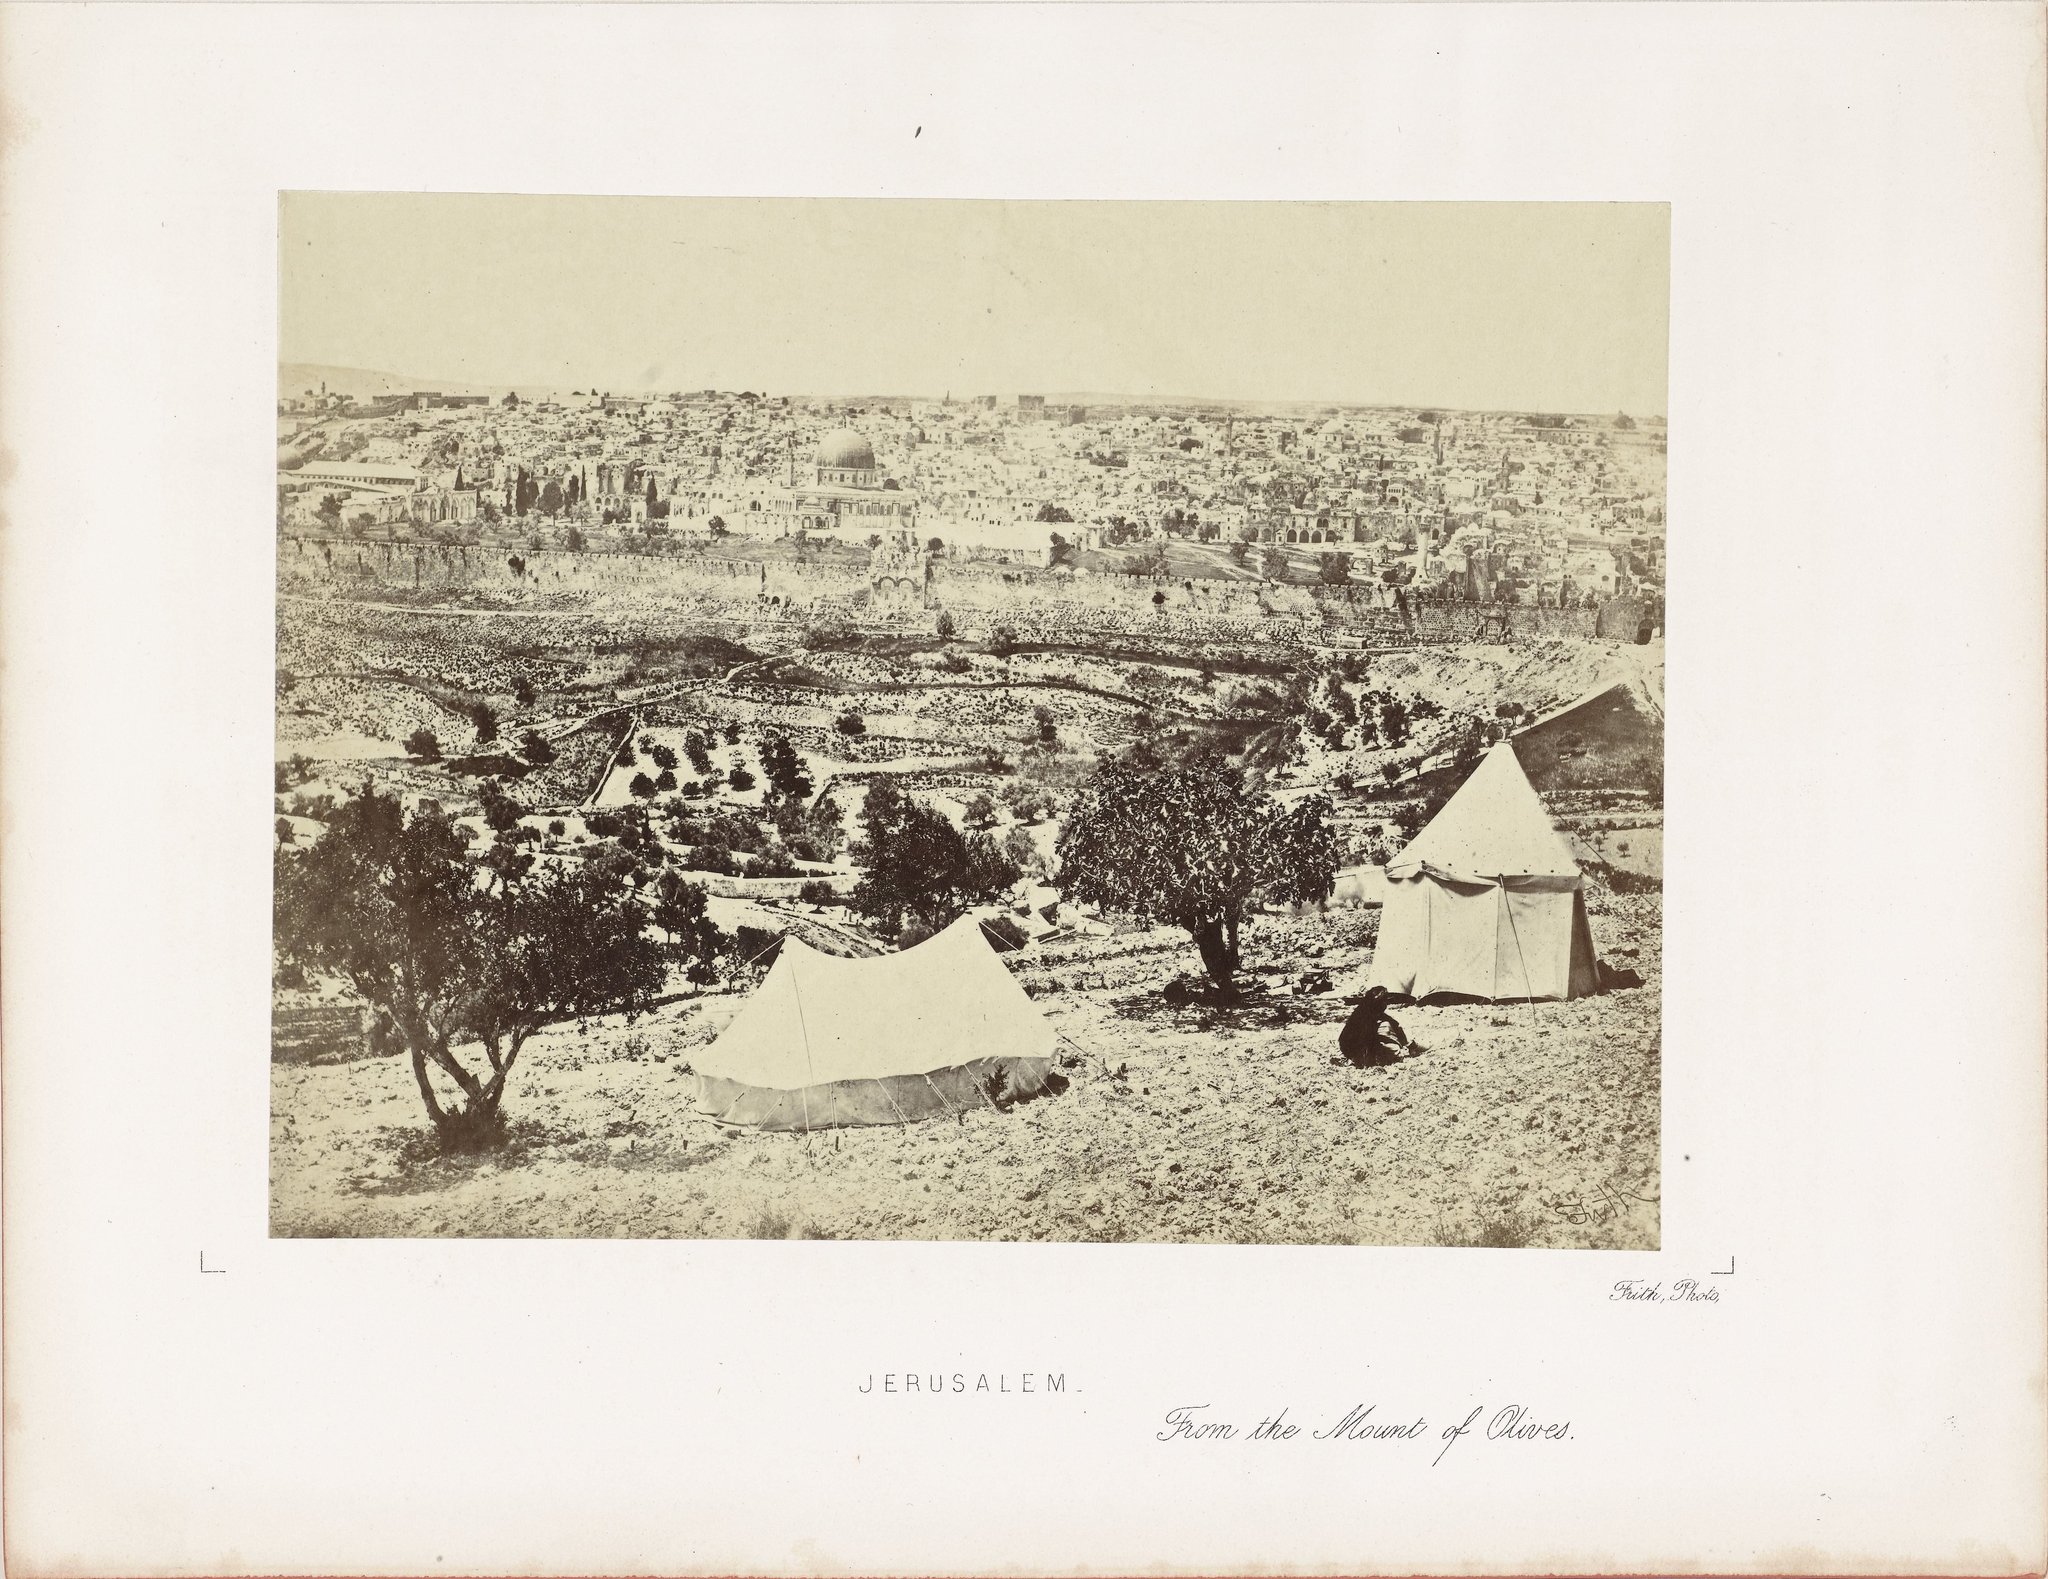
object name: photograph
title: Gezicht op Jeruzalem vanaf de Olijfberg, op de voorgrond twee tenten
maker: francis frith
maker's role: publisher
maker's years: 1822-1898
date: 1857-1858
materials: cardboard, paper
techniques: albumen print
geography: jerusalem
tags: city-view in general; 'veduta'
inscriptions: inscription: ‘Foto 1857 Hykens [?] Francis Frith Sinai and Palestine, waar parallel-/ opnamen’